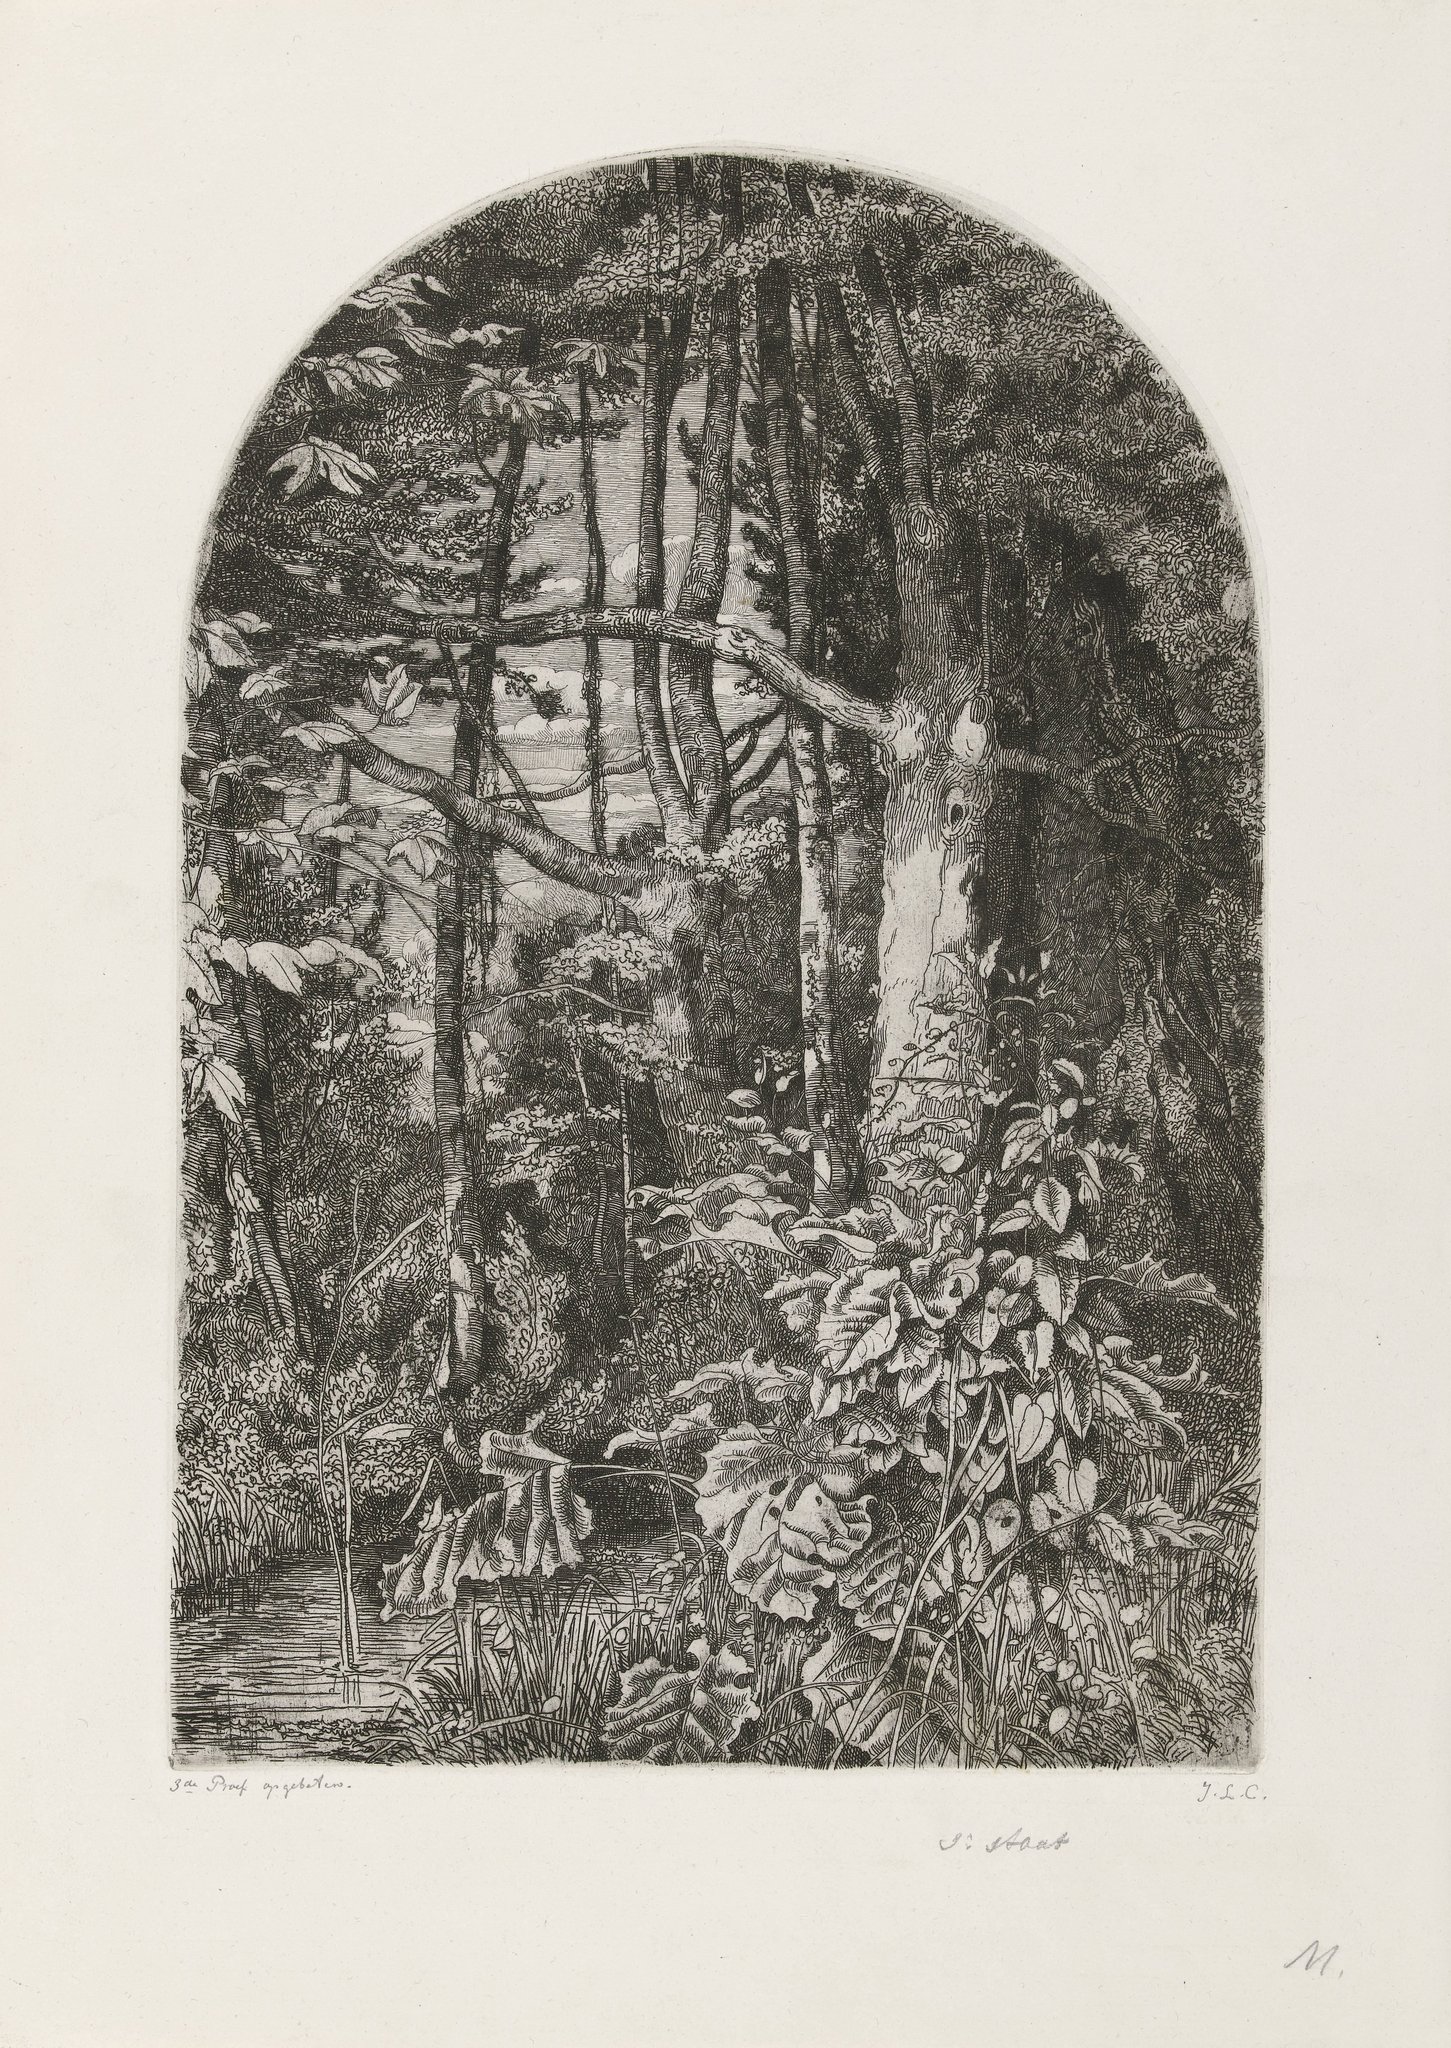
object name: print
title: Bos met beek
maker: jacobus ludovicus cornet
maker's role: draughtsman, print maker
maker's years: 1815-1882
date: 1825-1882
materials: paper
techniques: etching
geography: leiden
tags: brook, deciduous forest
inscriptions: collector's mark: Lugt 2166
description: Een dichtbegroeid woud. Een klein beekje stroomt van links naar rechts.